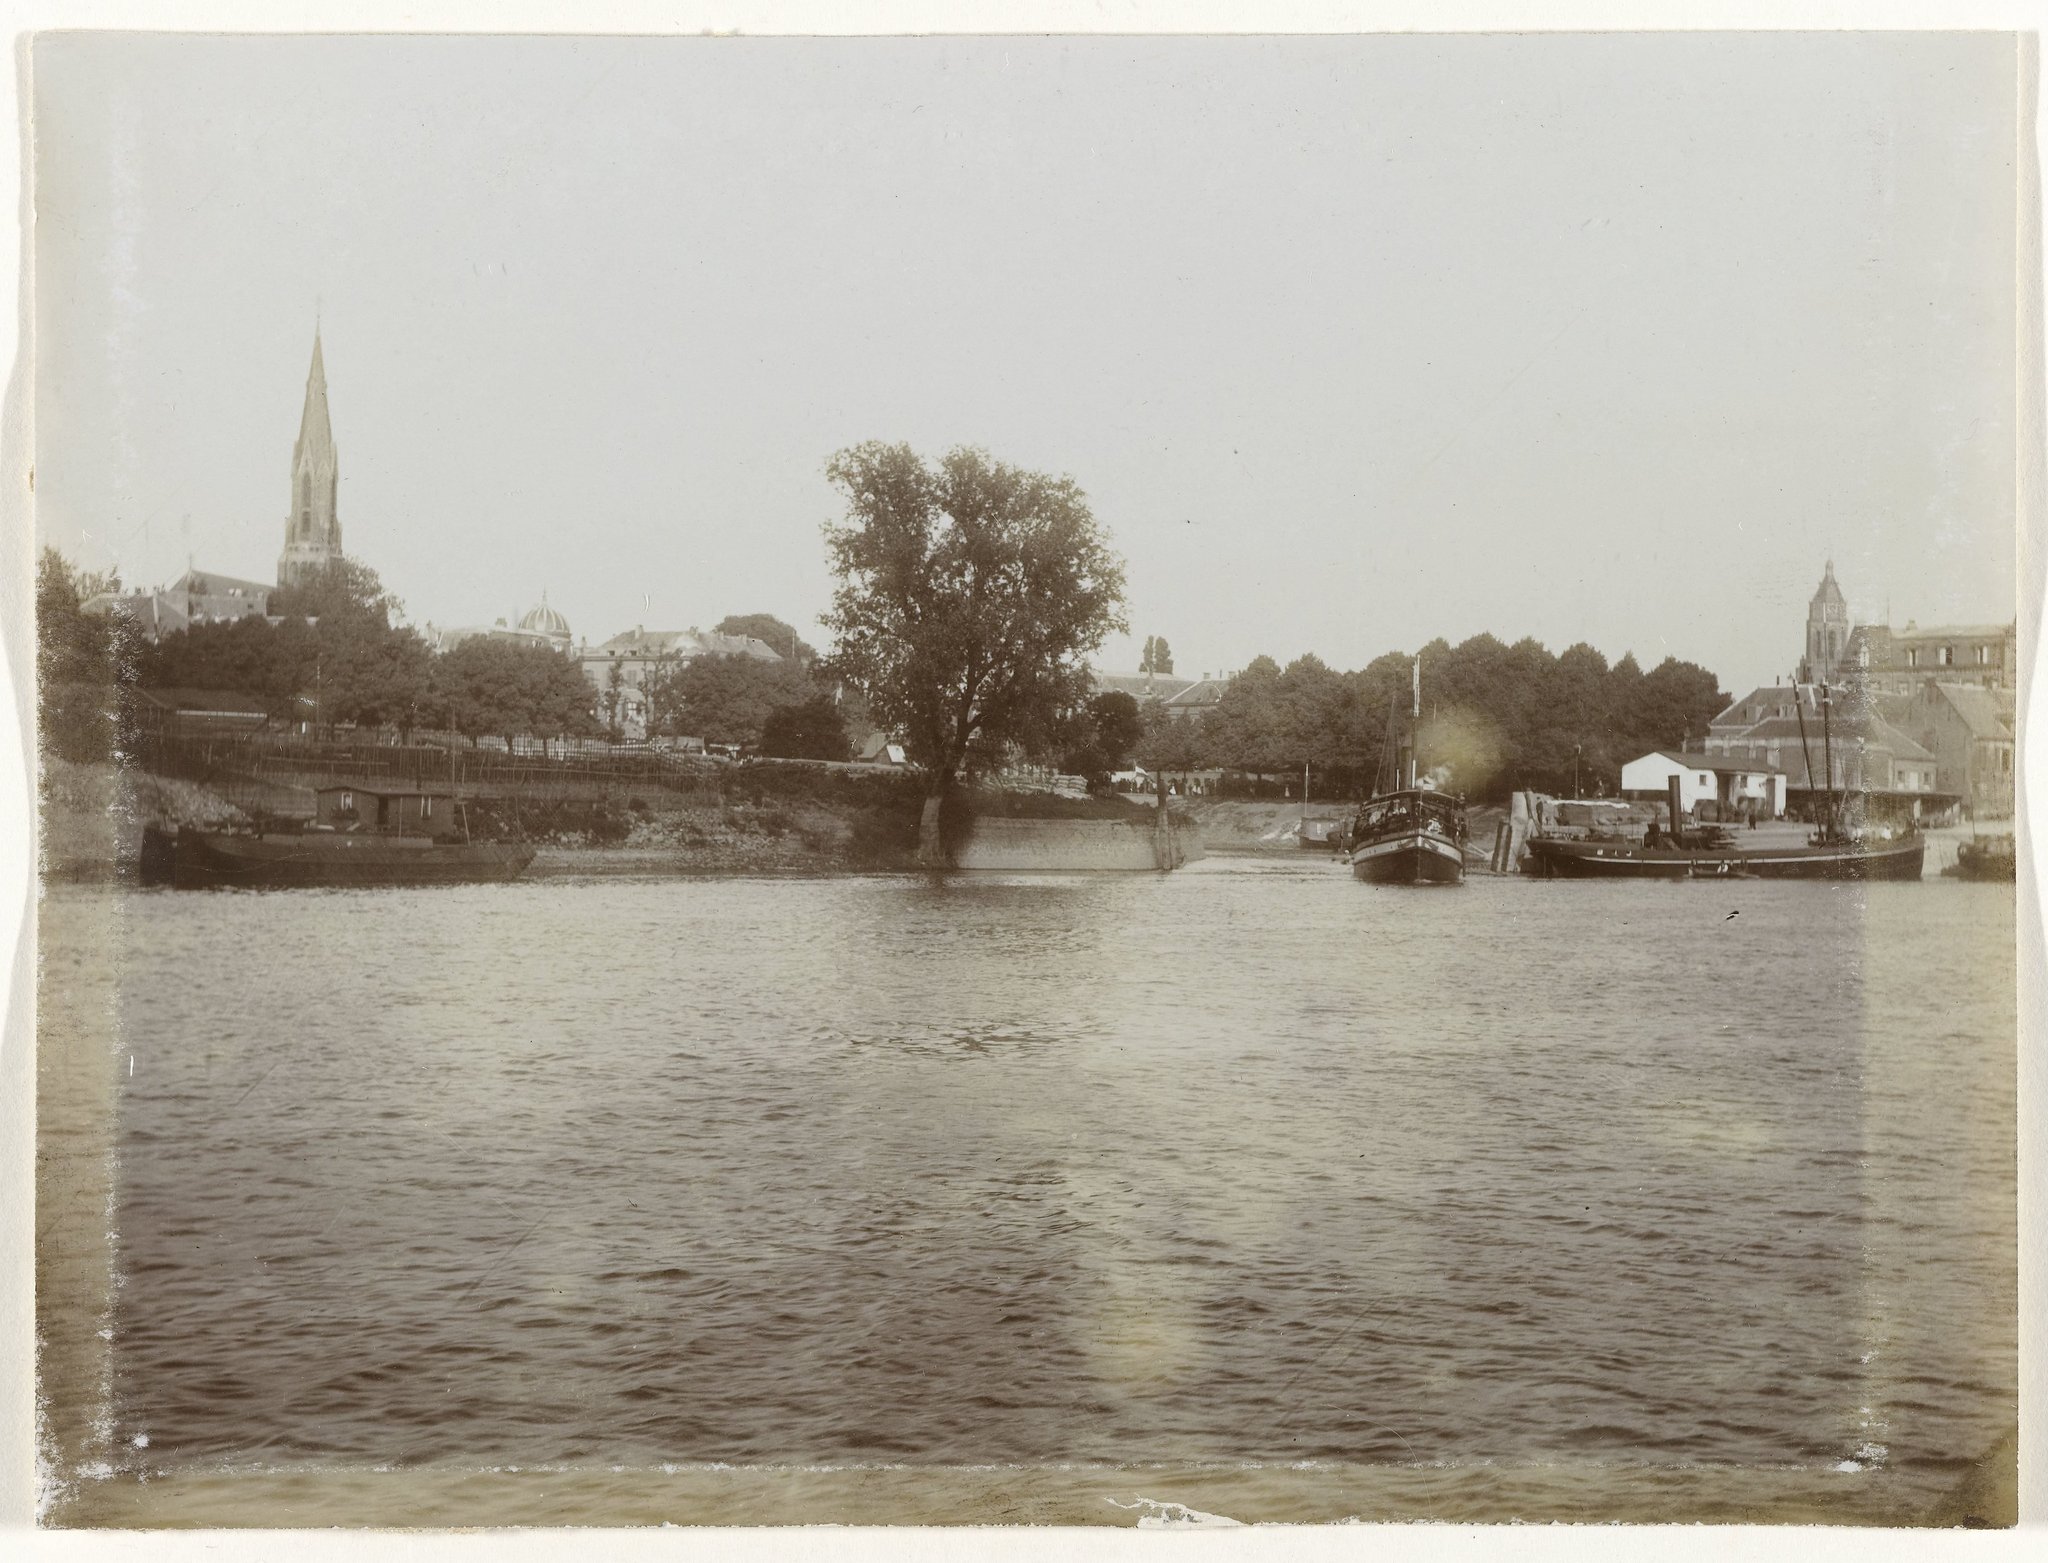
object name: photograph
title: Gezicht op de oude haven in Arnhem, links de Kleine Eusebiuskerk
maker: Anonymous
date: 1900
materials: paper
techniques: collodion silver print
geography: arnhem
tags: harbour